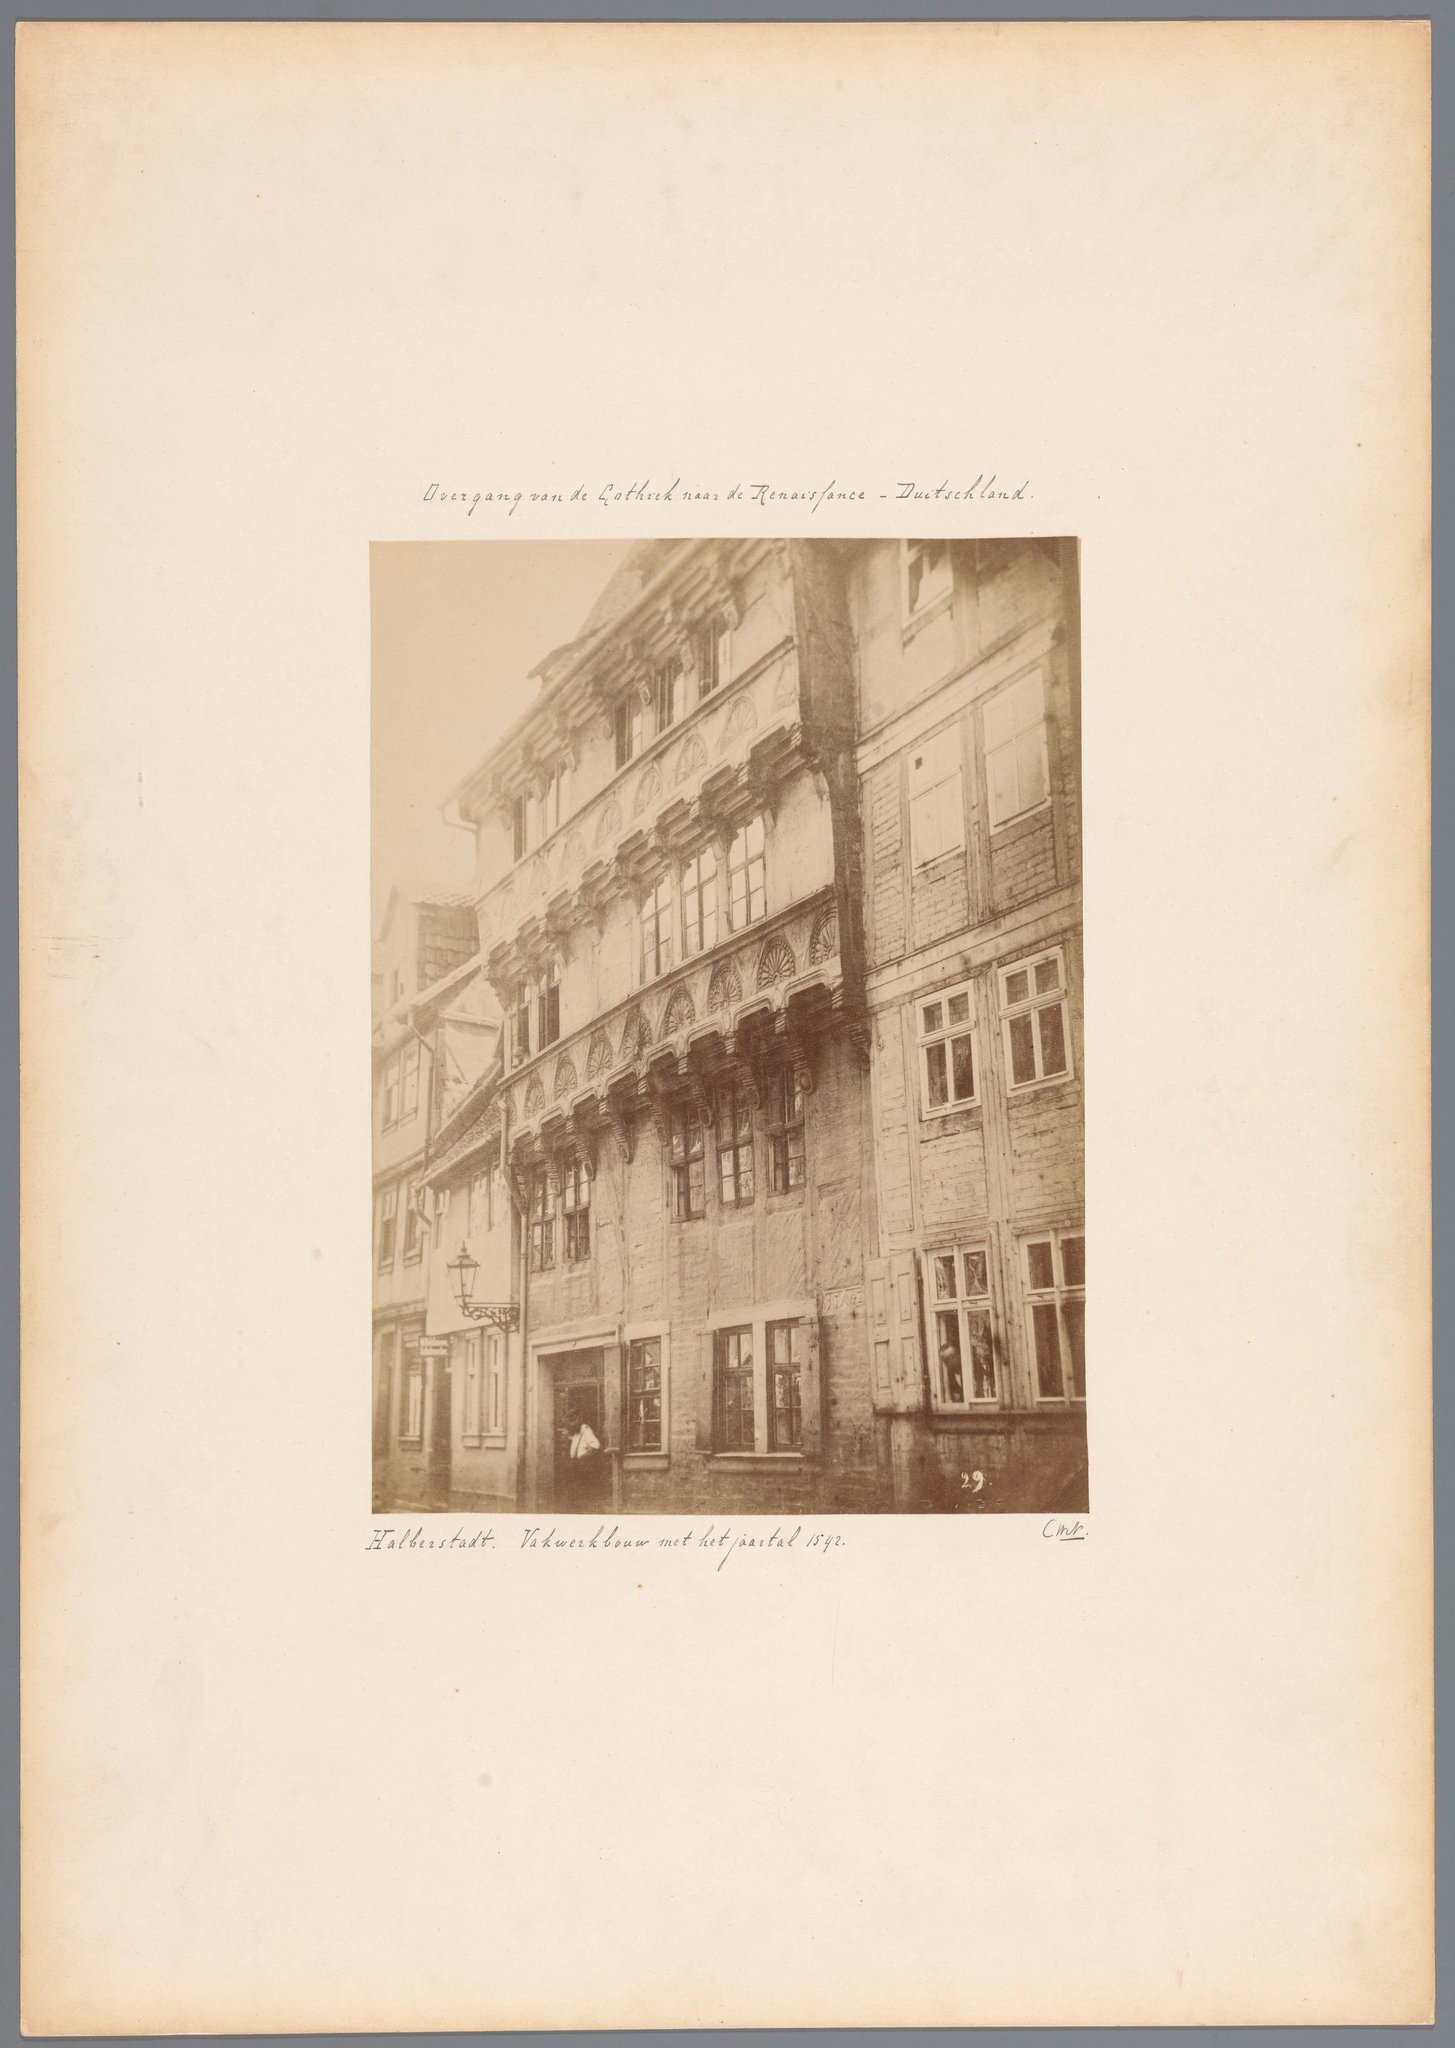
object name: photograph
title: Halberstadt. Vakwerkbouw met het jaartal 1542.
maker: Anonymous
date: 1875-1900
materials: cardboard, photographic support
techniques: albumen print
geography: halberstadt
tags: urban housing, façade (of house or building)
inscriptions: collector's mark: ‘INSTITUUT VOOR KUNST-NIJVERHEIDSONDERWIJS GABRIËL METSUSTRAAT No. 16 AMSTERDAM’, inscription: ‘B.F.K. Rives’, inscription: ‘Overgang van de Gothiek naar de Renaissance - Duitschland.’, collector's mark: ‘KUNSTNIJVERHEIDSCHOOL QUELLINUS AMSTERDAM FRANS HALSSTRAAT 14.’, number: ‘29.’, inscription: ‘CWN.’